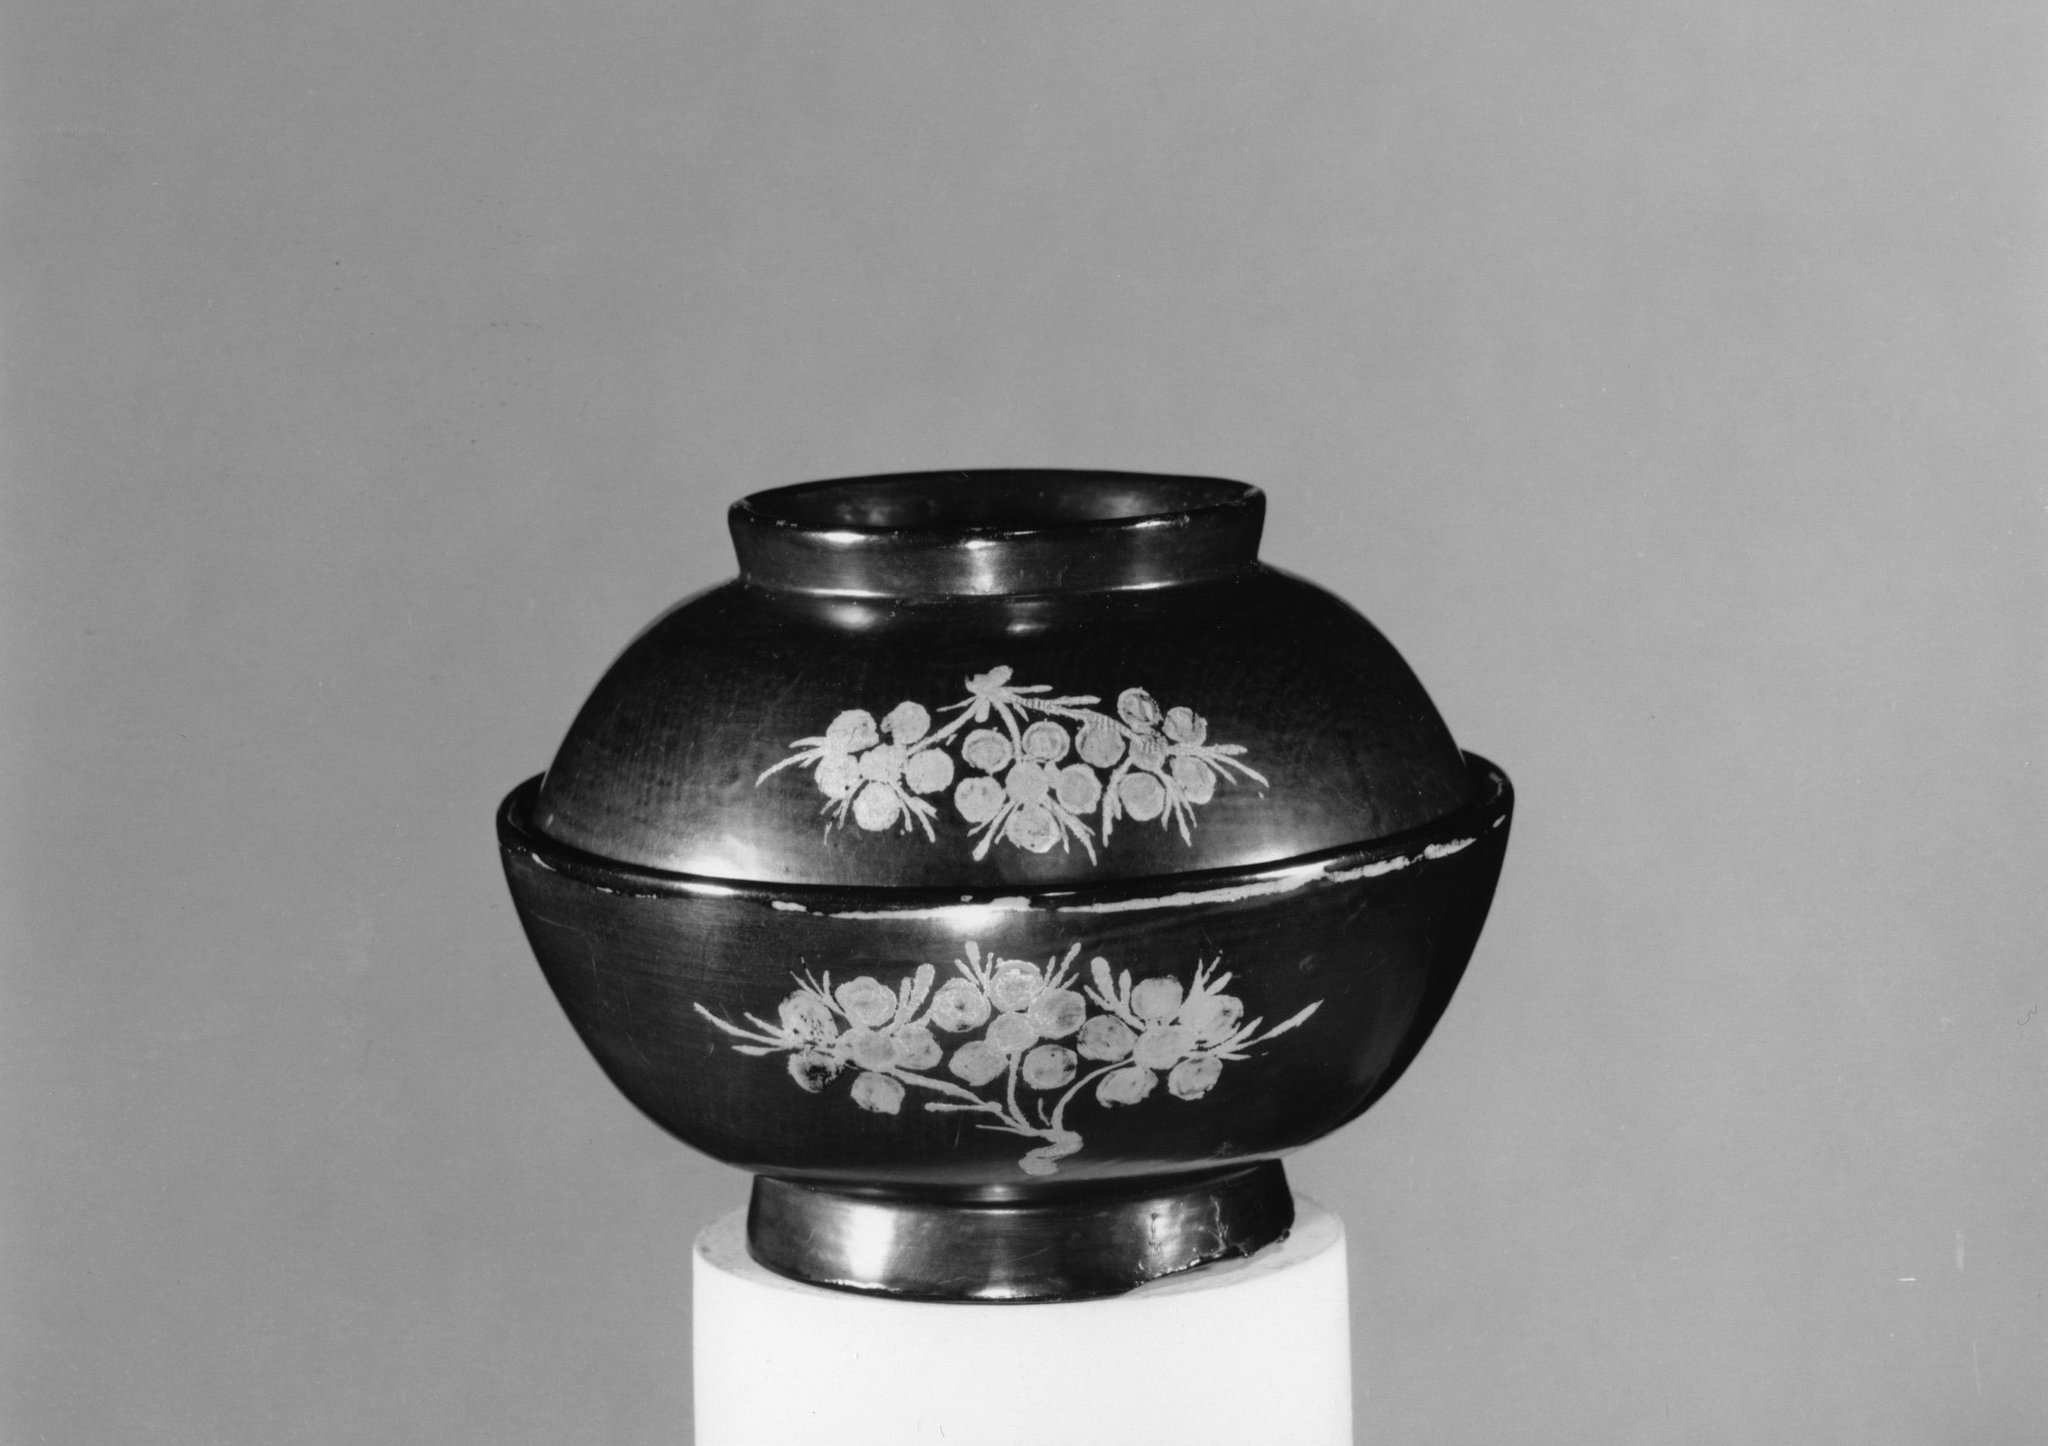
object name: bowl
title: Lidded Bowl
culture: japanese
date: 1701-1800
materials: gold, lacquer, wood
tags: flowers